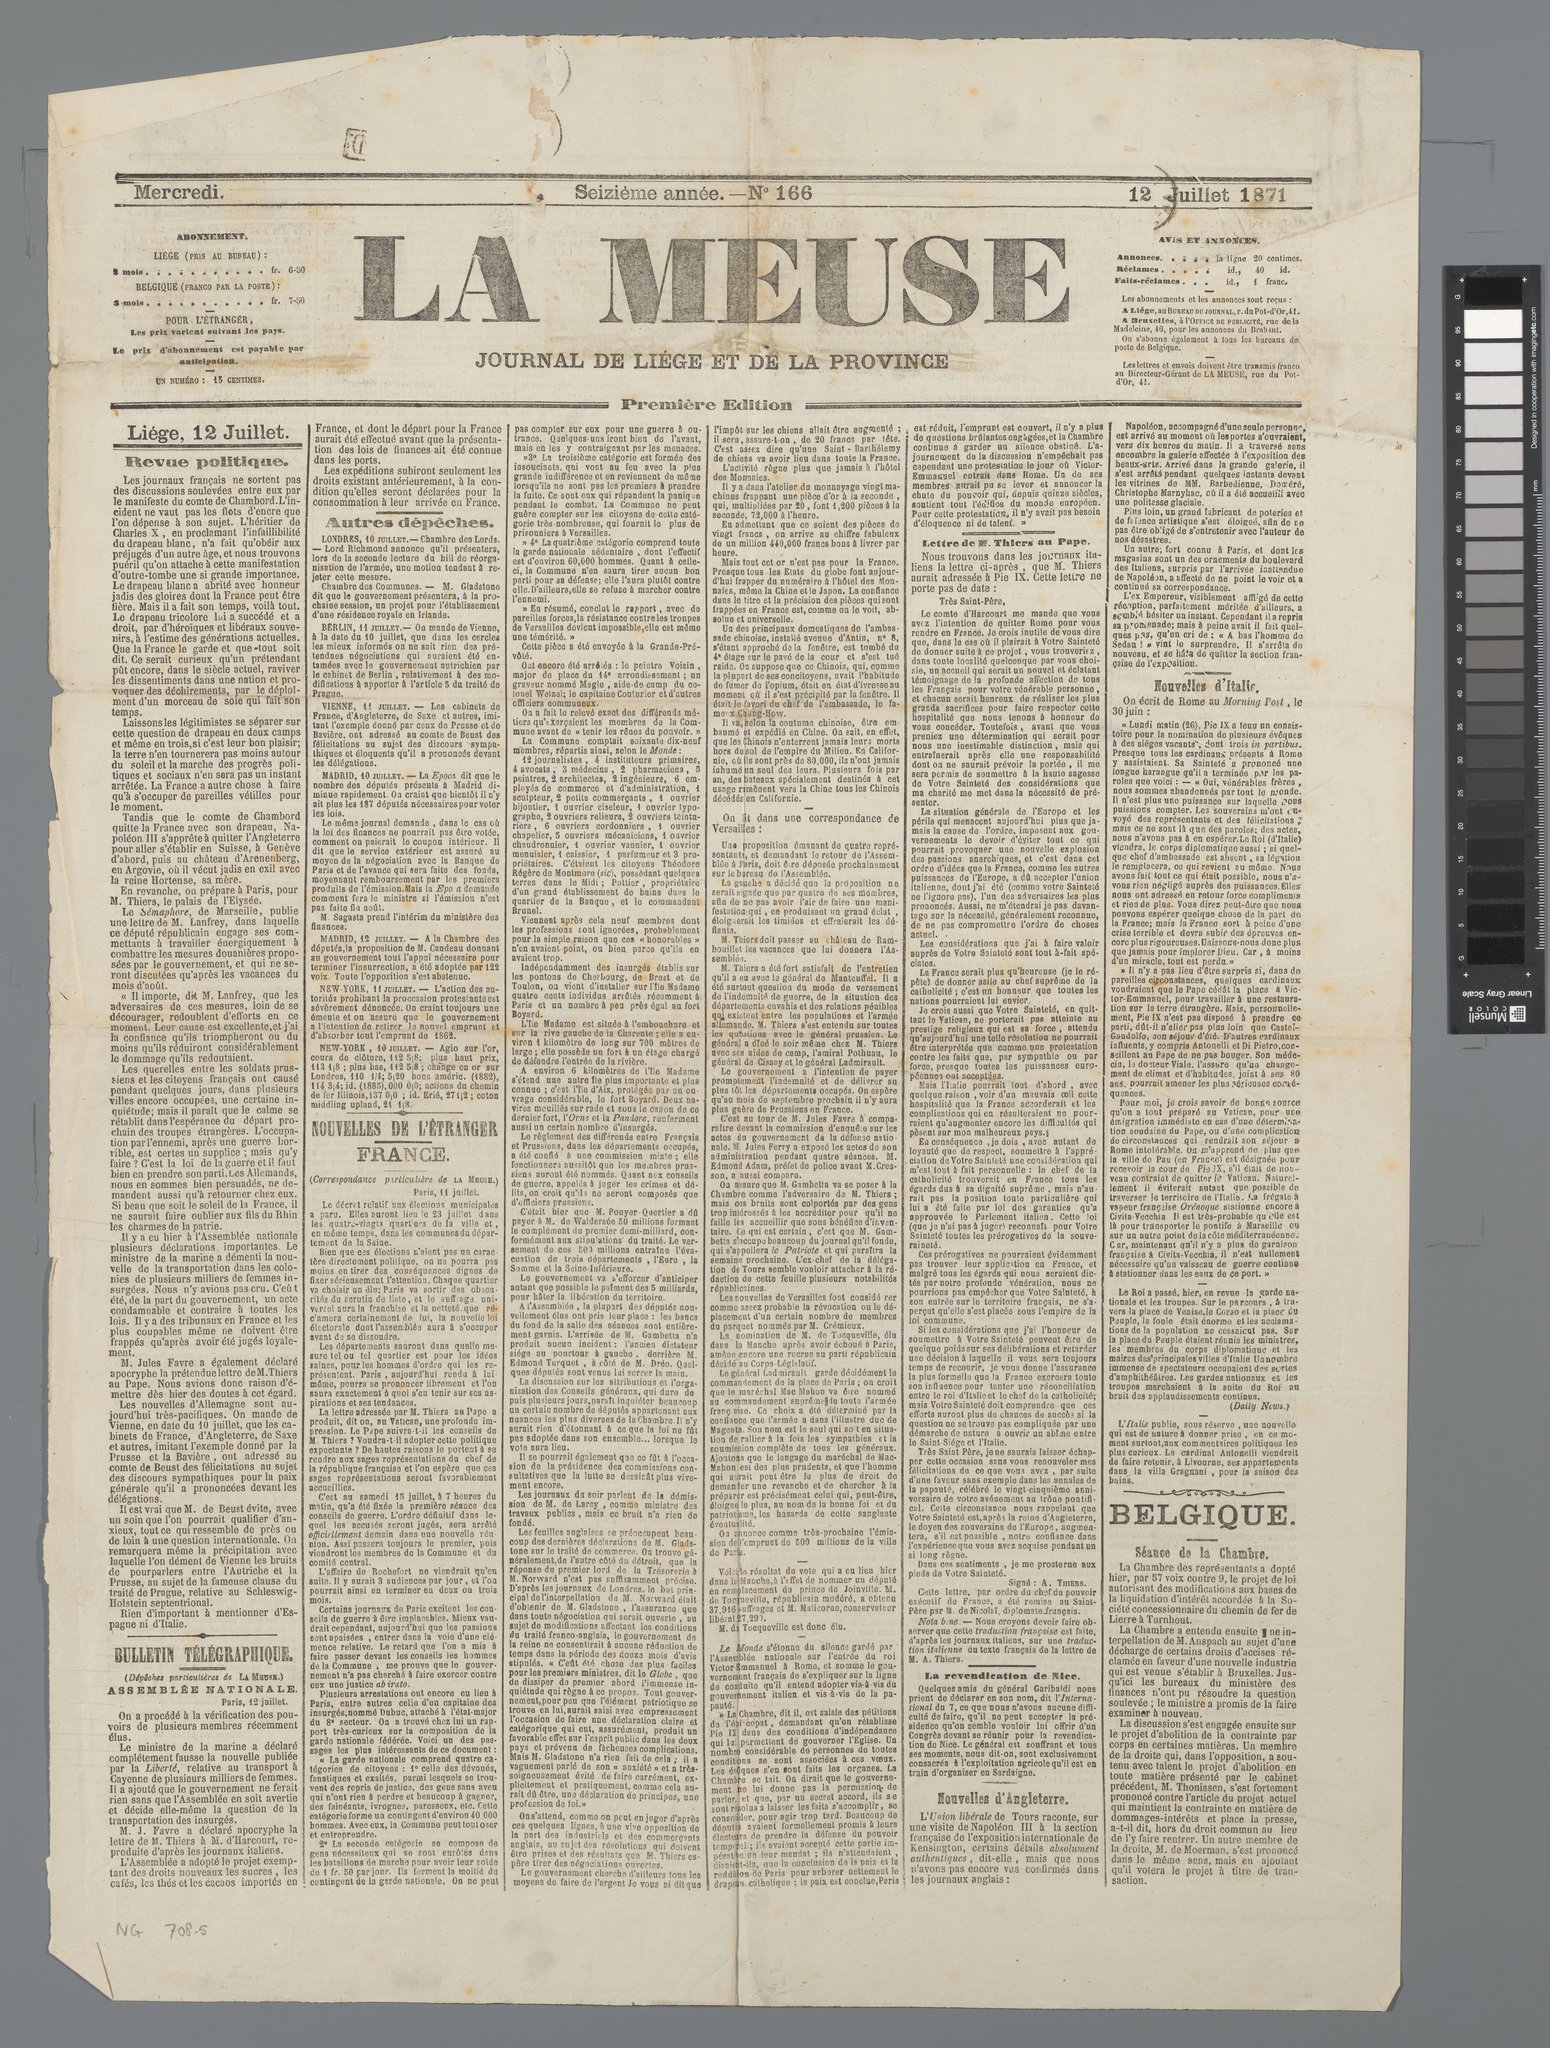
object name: newspaper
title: La Meuse, journal de Liège et de la Province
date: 1871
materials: paper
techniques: printing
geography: liège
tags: belgium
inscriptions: date